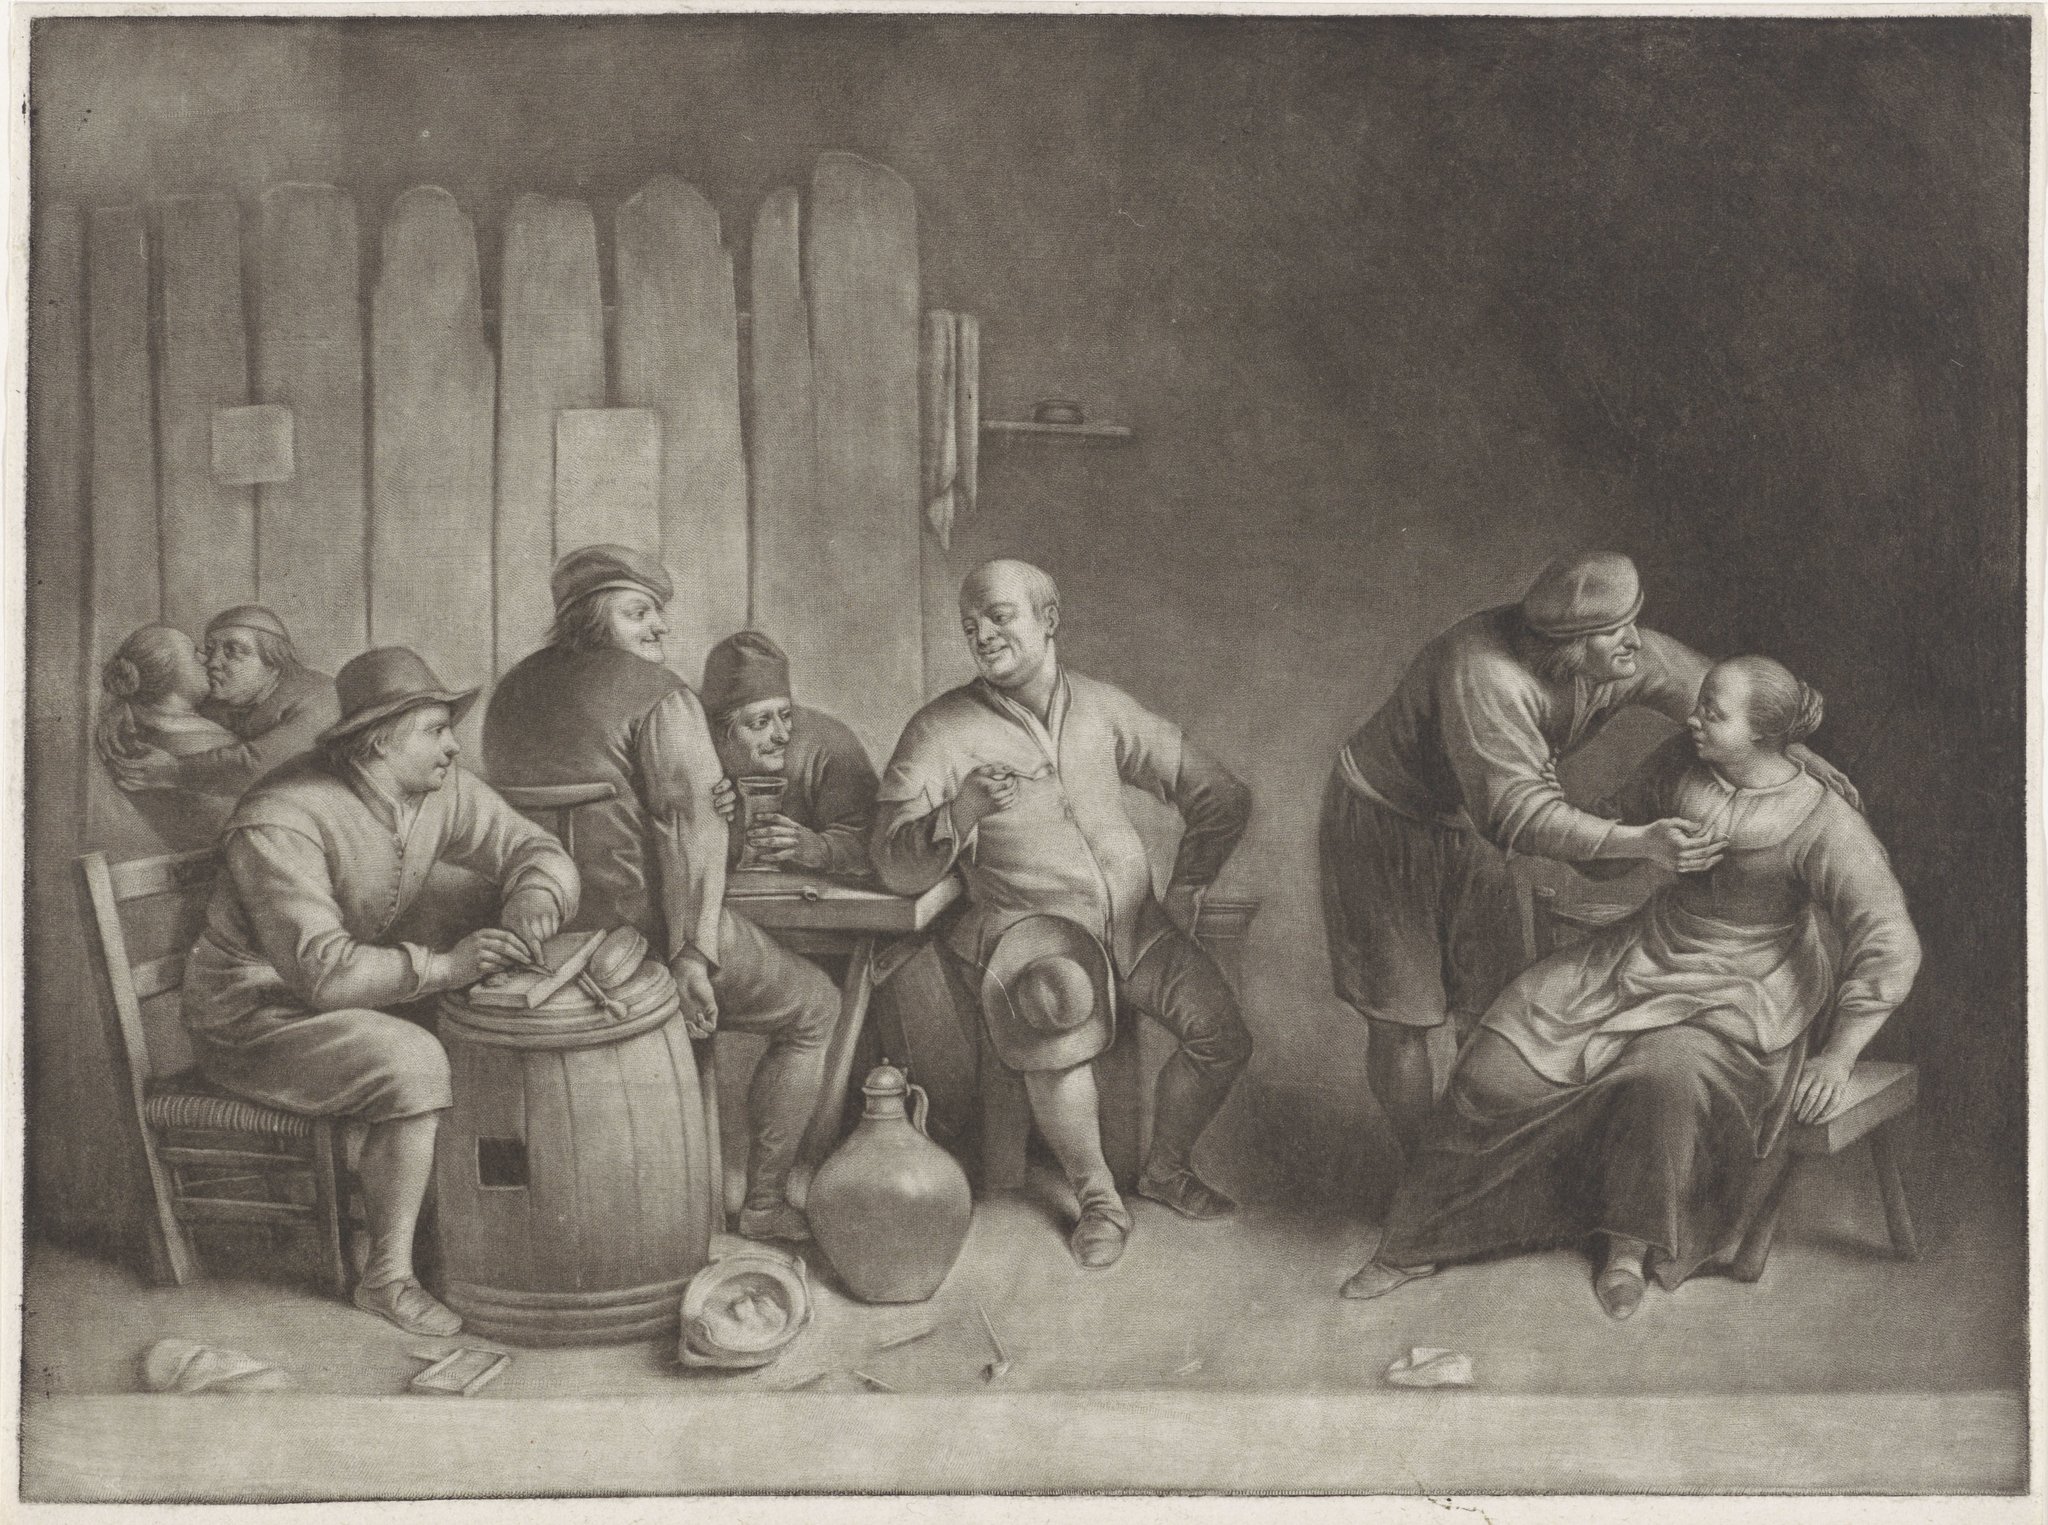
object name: print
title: Herbergscène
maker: Anonymous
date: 1650-1800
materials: paper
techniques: mezzotint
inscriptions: collector's mark: Lugt 2228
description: In een herberg zitten enkele mannen aan tafel te praten, drinken en te roken. Op de voorgrond maakt een man advances naar een vrouw, die hem afwijst. Op de achtergrond probeert een van de mannen een vrouw te zoenen, maar zij deinst achterover en weert hem af.